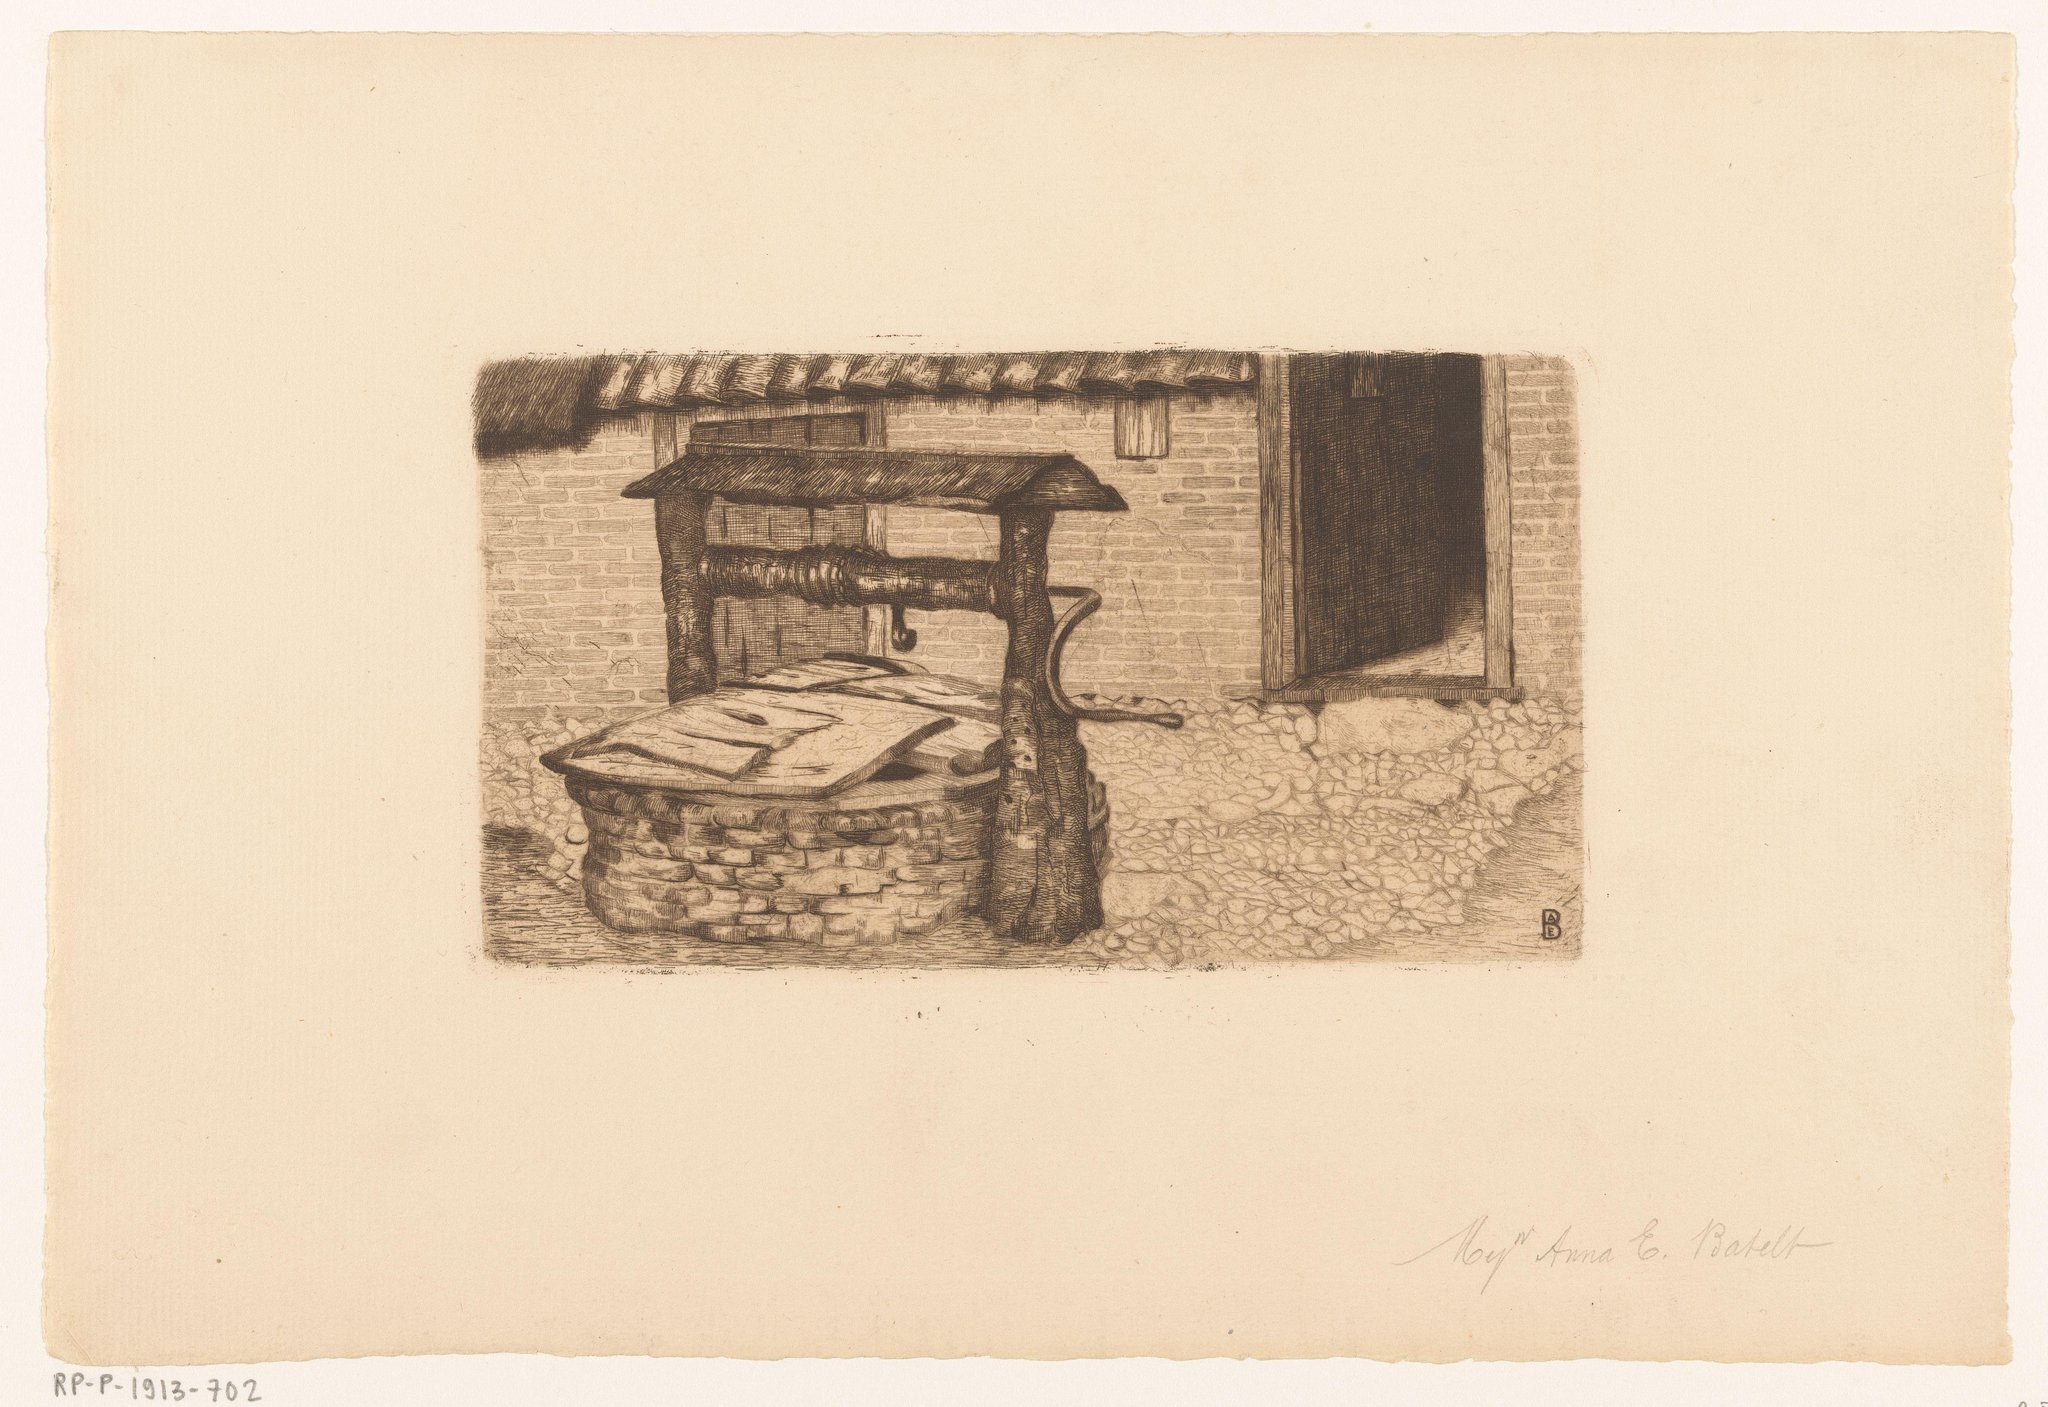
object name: print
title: Waterput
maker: anna elisabeth batelt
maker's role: draughtsman, painter, print maker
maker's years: 1869-1921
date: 1879-1913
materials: paper, ink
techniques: drypoint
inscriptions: inscription: ‘Mej. Anna E. Batelt’, collector's mark: Lugt 2233, monogram: ‘BAE’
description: Waterput met daarop een aantal planken, op de achtergrond de gevel van een huis.